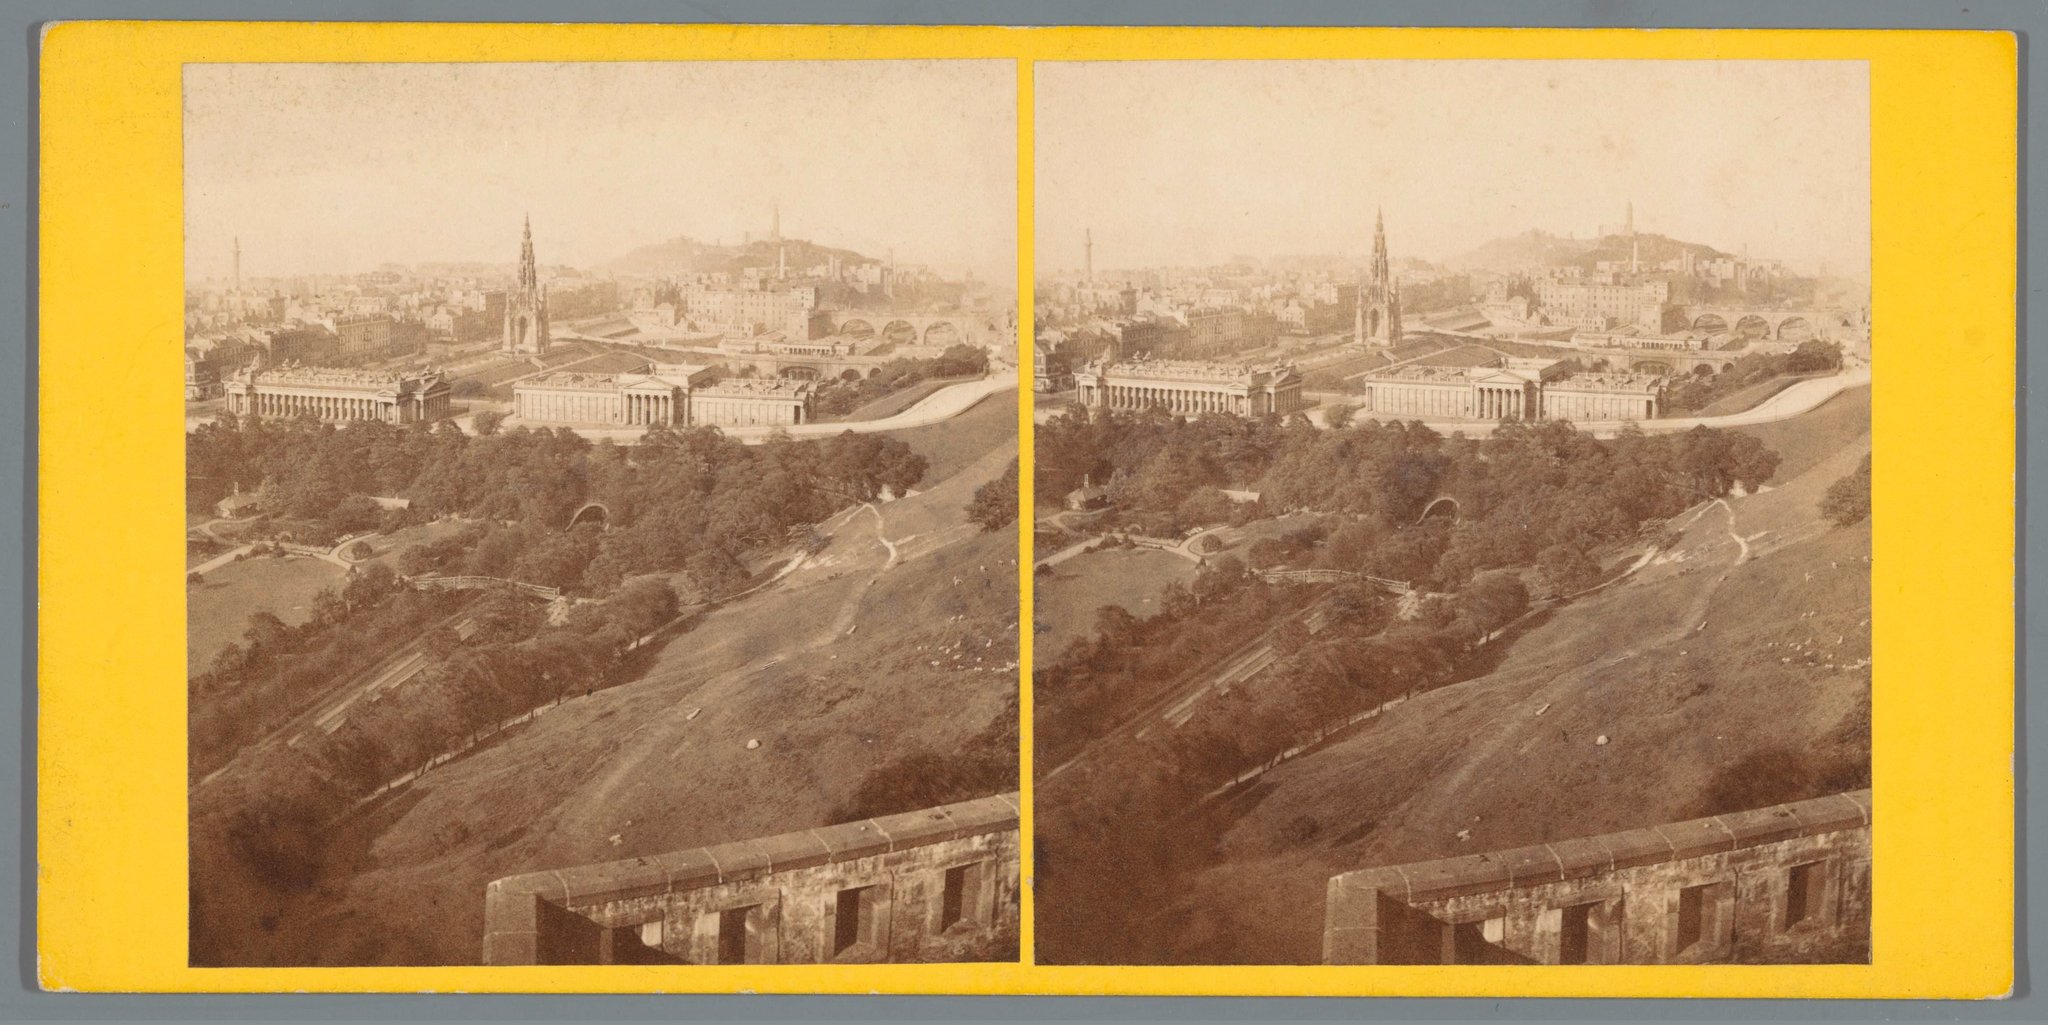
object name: stereograph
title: Edinburgh from the Castle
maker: george washington wilson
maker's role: publisher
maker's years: 1823-1893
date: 1860-1865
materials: cardboard, photographic support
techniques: albumen print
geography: aberdeen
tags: schotland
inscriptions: label: ‘G.W. Wilson & Co, Aberdeen No. 865 Edinburgh from the Castle’